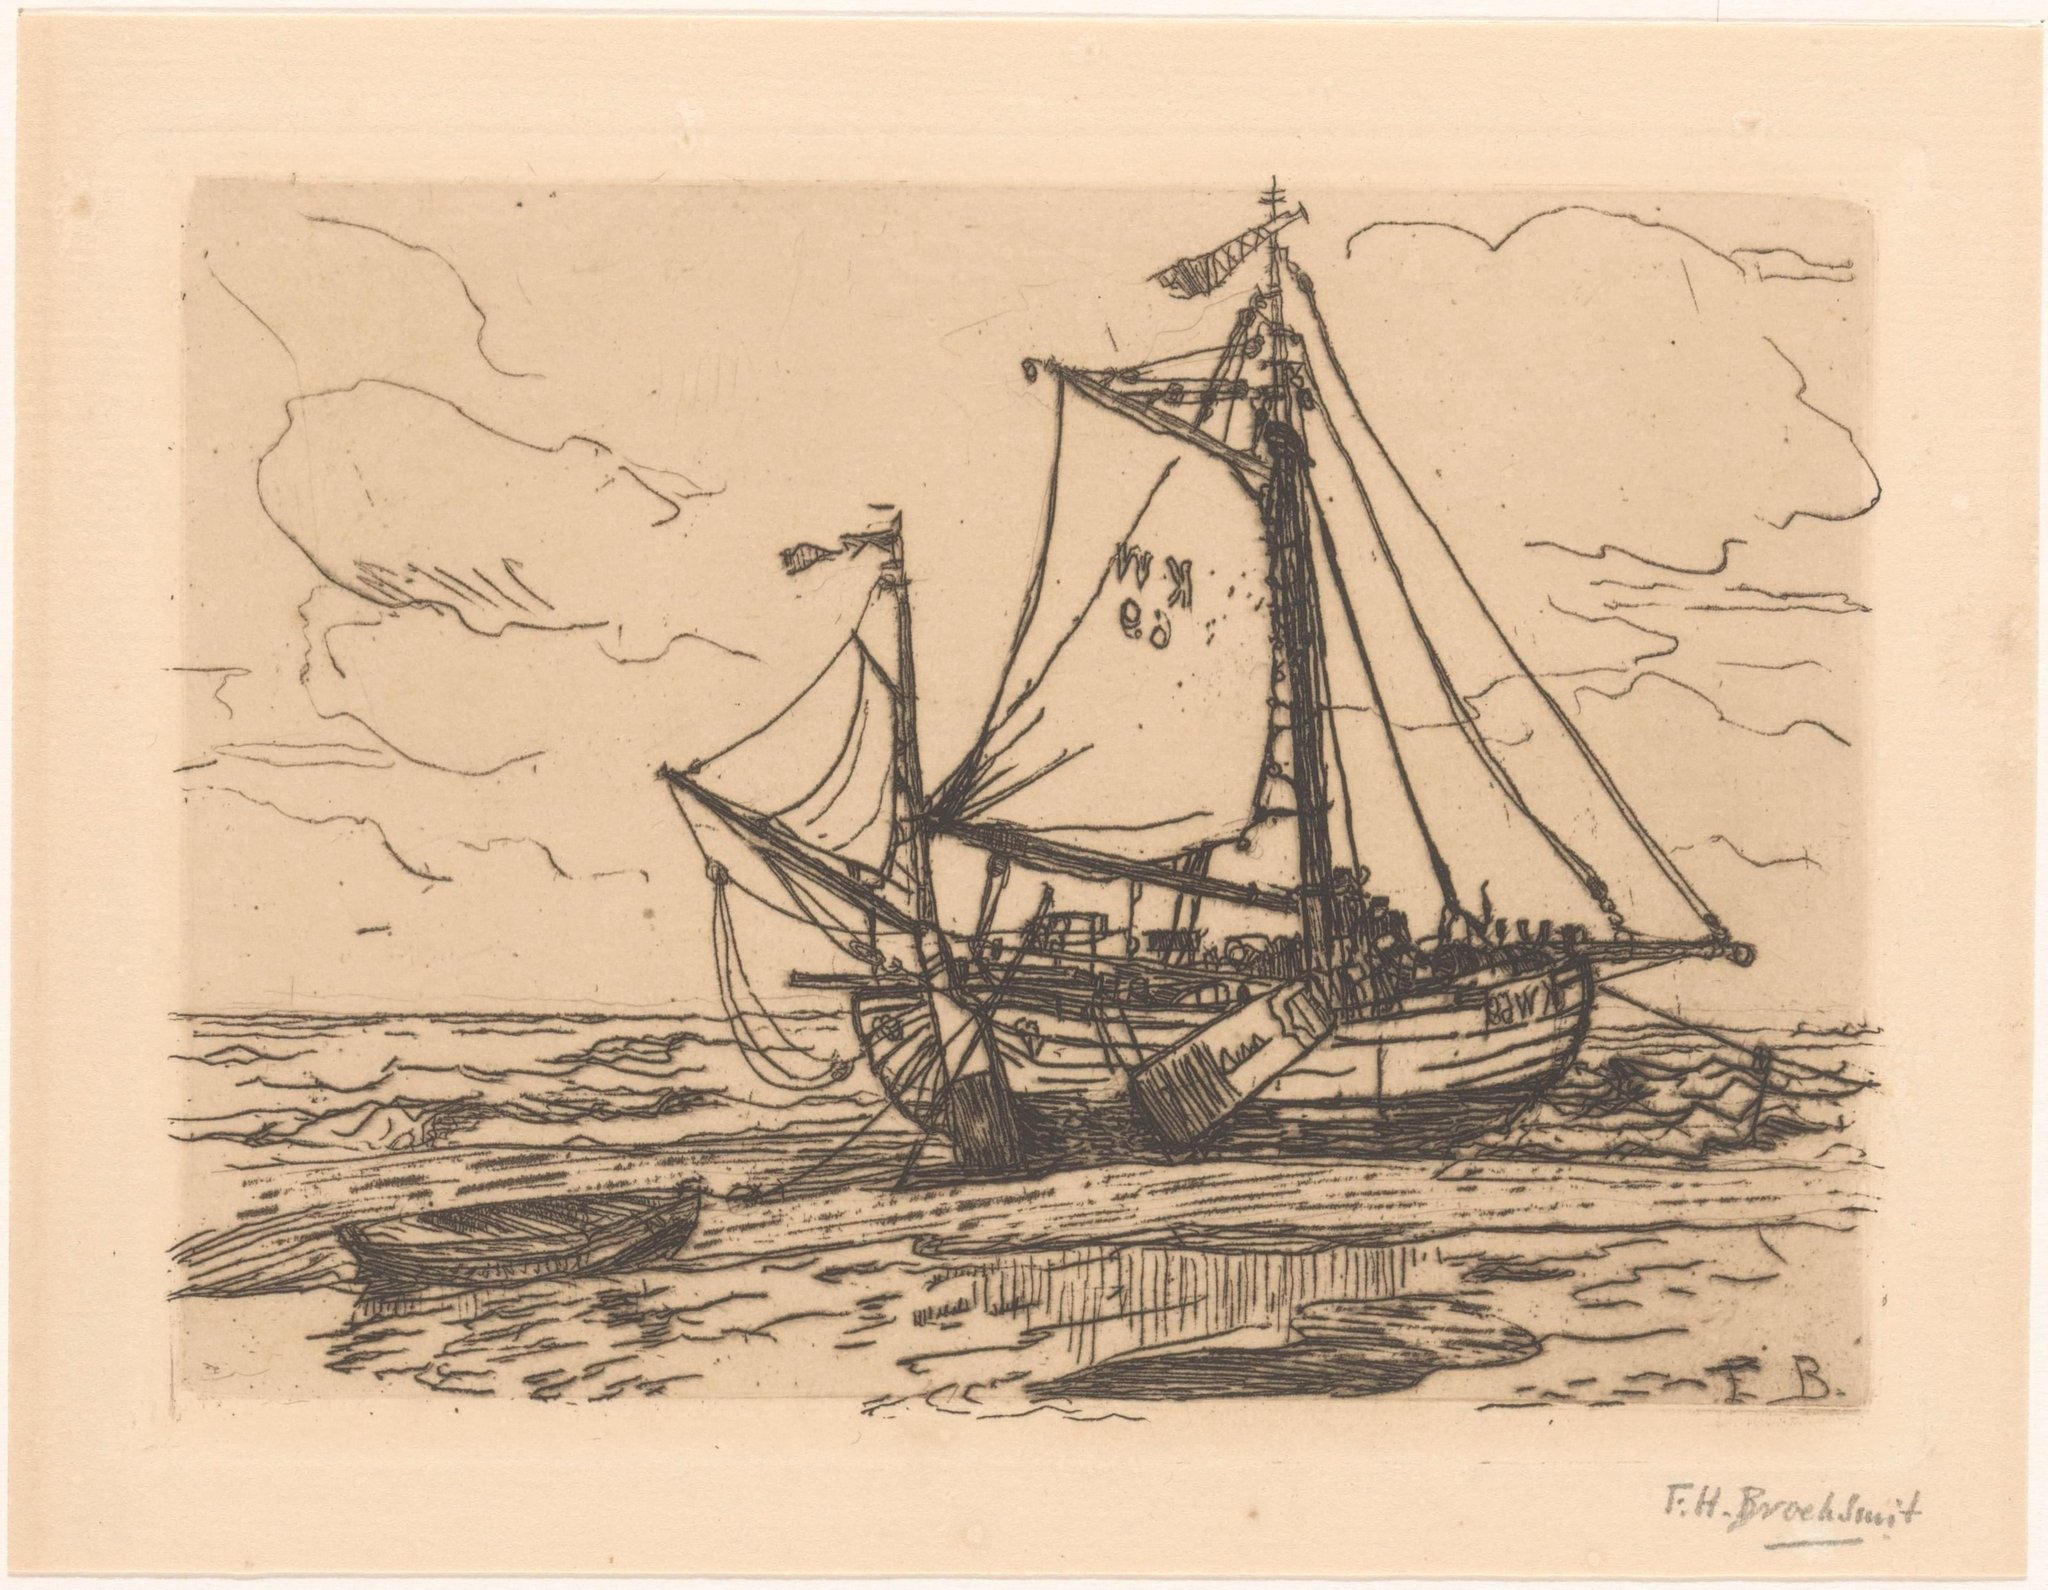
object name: print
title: Bomschuit bij vloed op strand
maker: frederika henriëtte broeksmit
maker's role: draughtsman, print maker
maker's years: 1875-1945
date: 1885-1931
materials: paper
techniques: etching, intaglio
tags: flood, high tide, ships, boats on land, beached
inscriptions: collector's mark: Lugt 2228